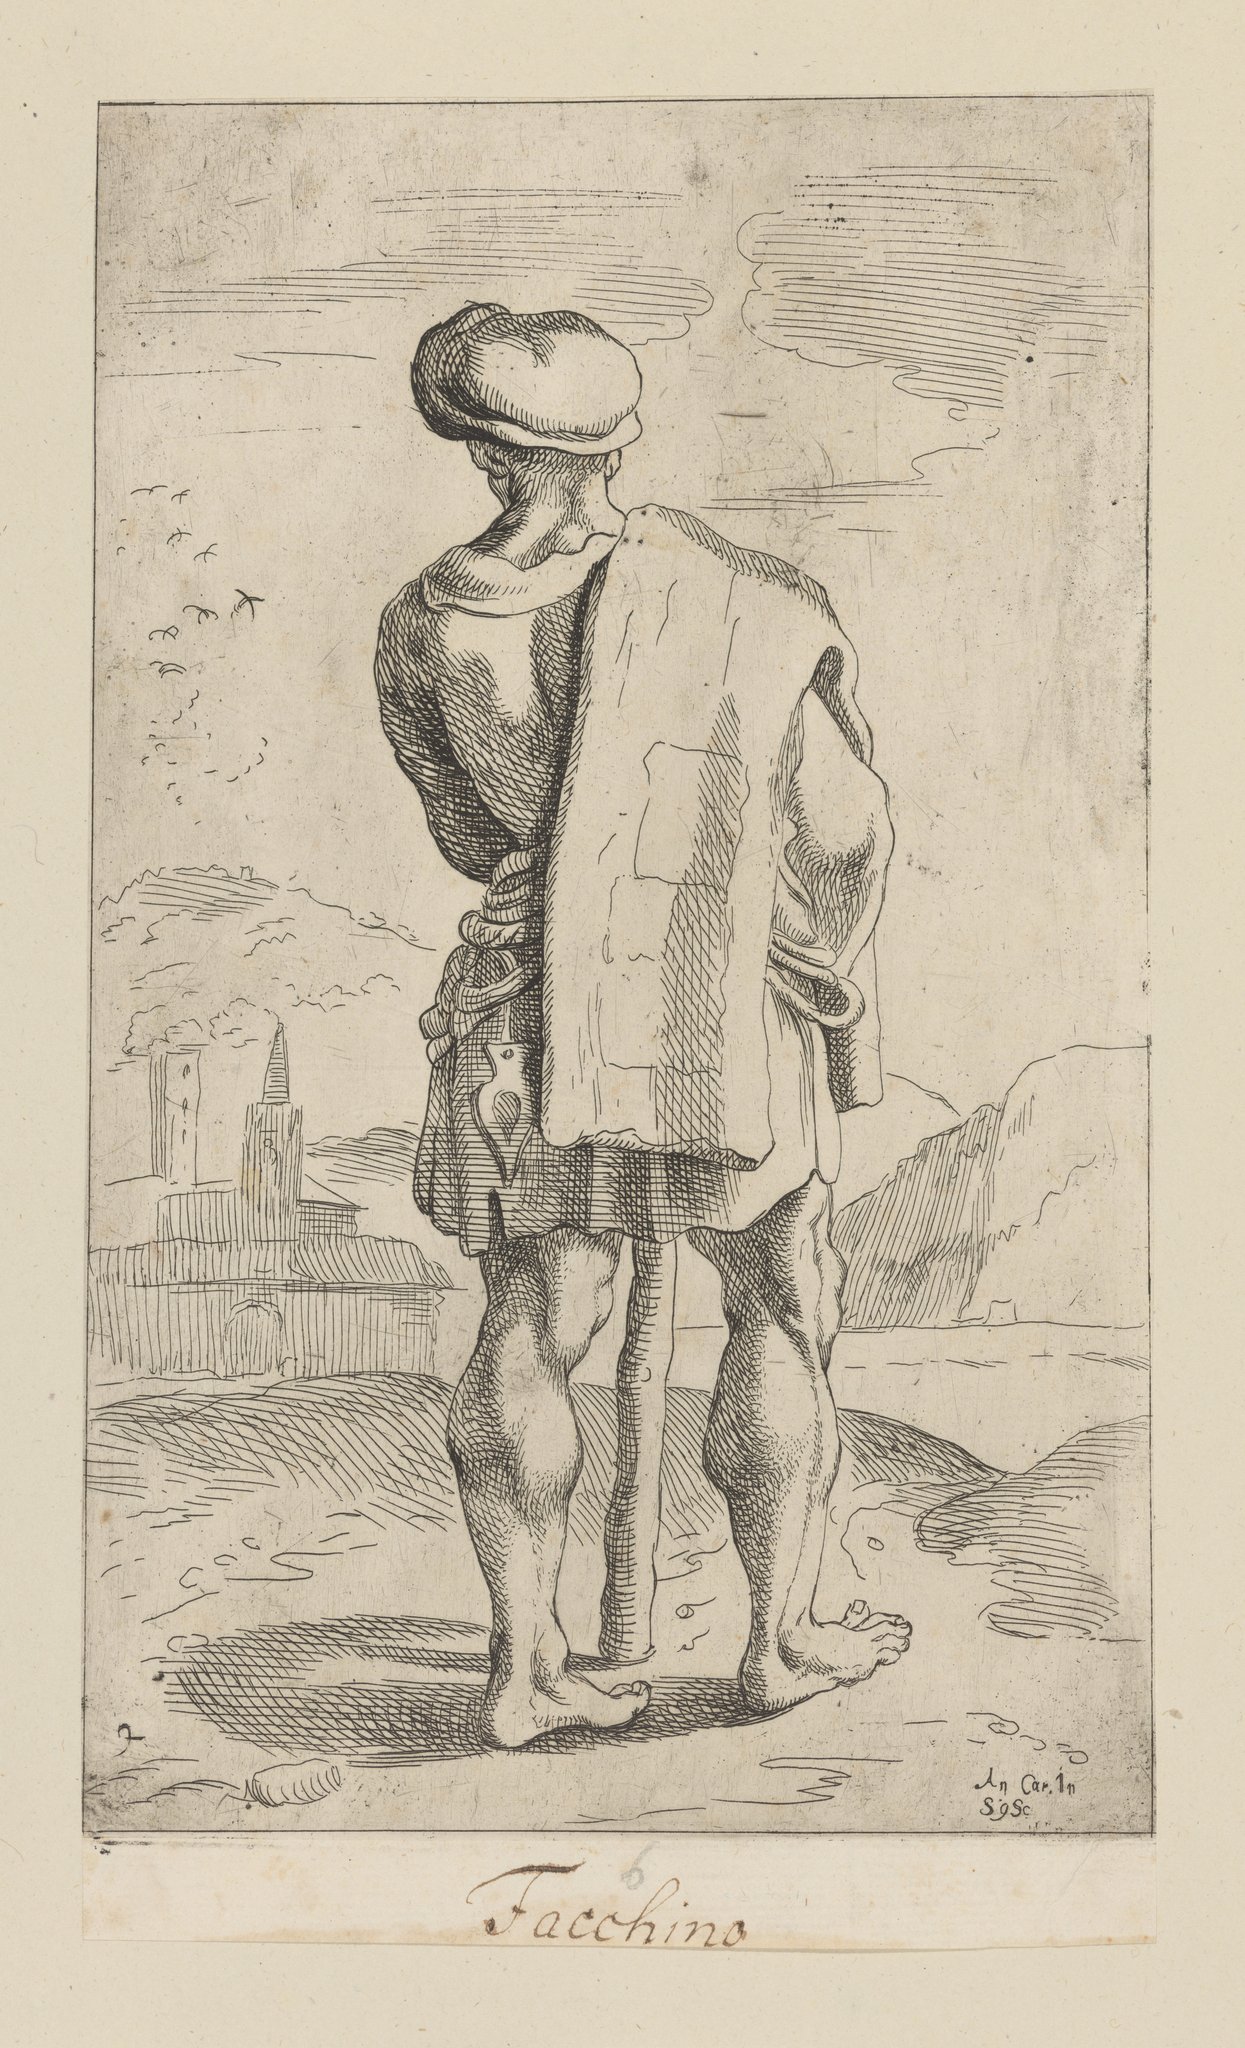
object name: print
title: Plate 2: Porter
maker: simon guillain ii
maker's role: artist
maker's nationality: french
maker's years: 1618-1718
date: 1646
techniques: etching